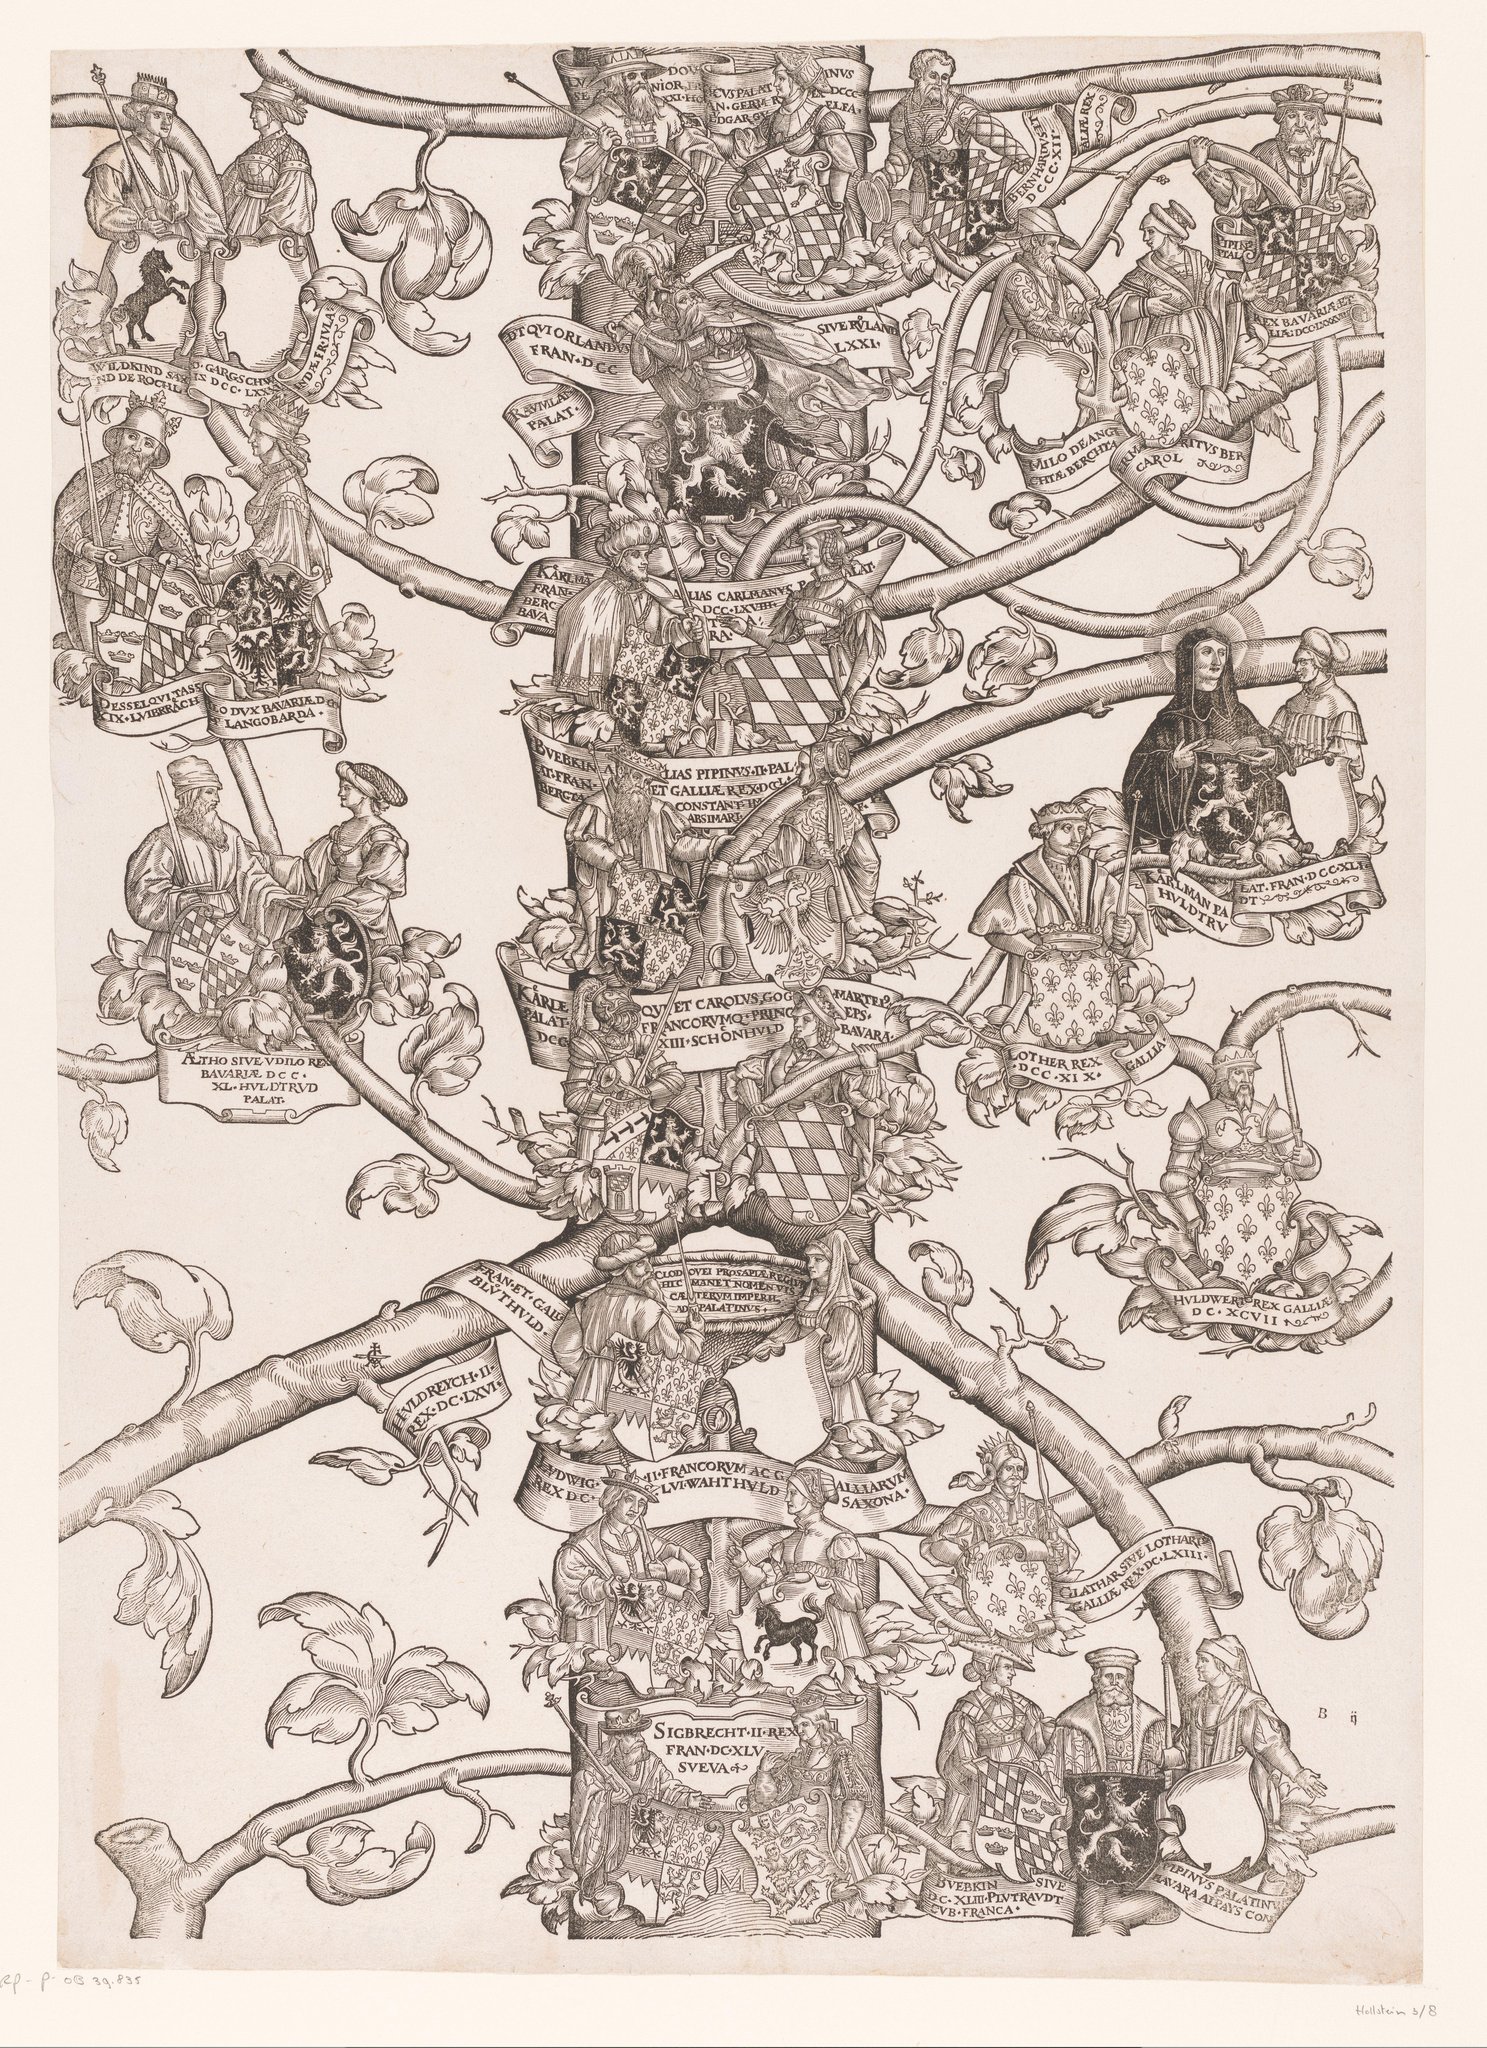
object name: print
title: Stamboom van Frederik en Ottheinrich van Palts-Neuburg (plaat 8)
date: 1535-1594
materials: paper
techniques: letterpress printing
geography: basel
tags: earl, family lineage, pedigree, genealogical tree or table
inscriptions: collector's mark: Lugt 240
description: Blad 8 van een stamboom bestaande uit 21 bladen, gedrukt van 42 blokken.